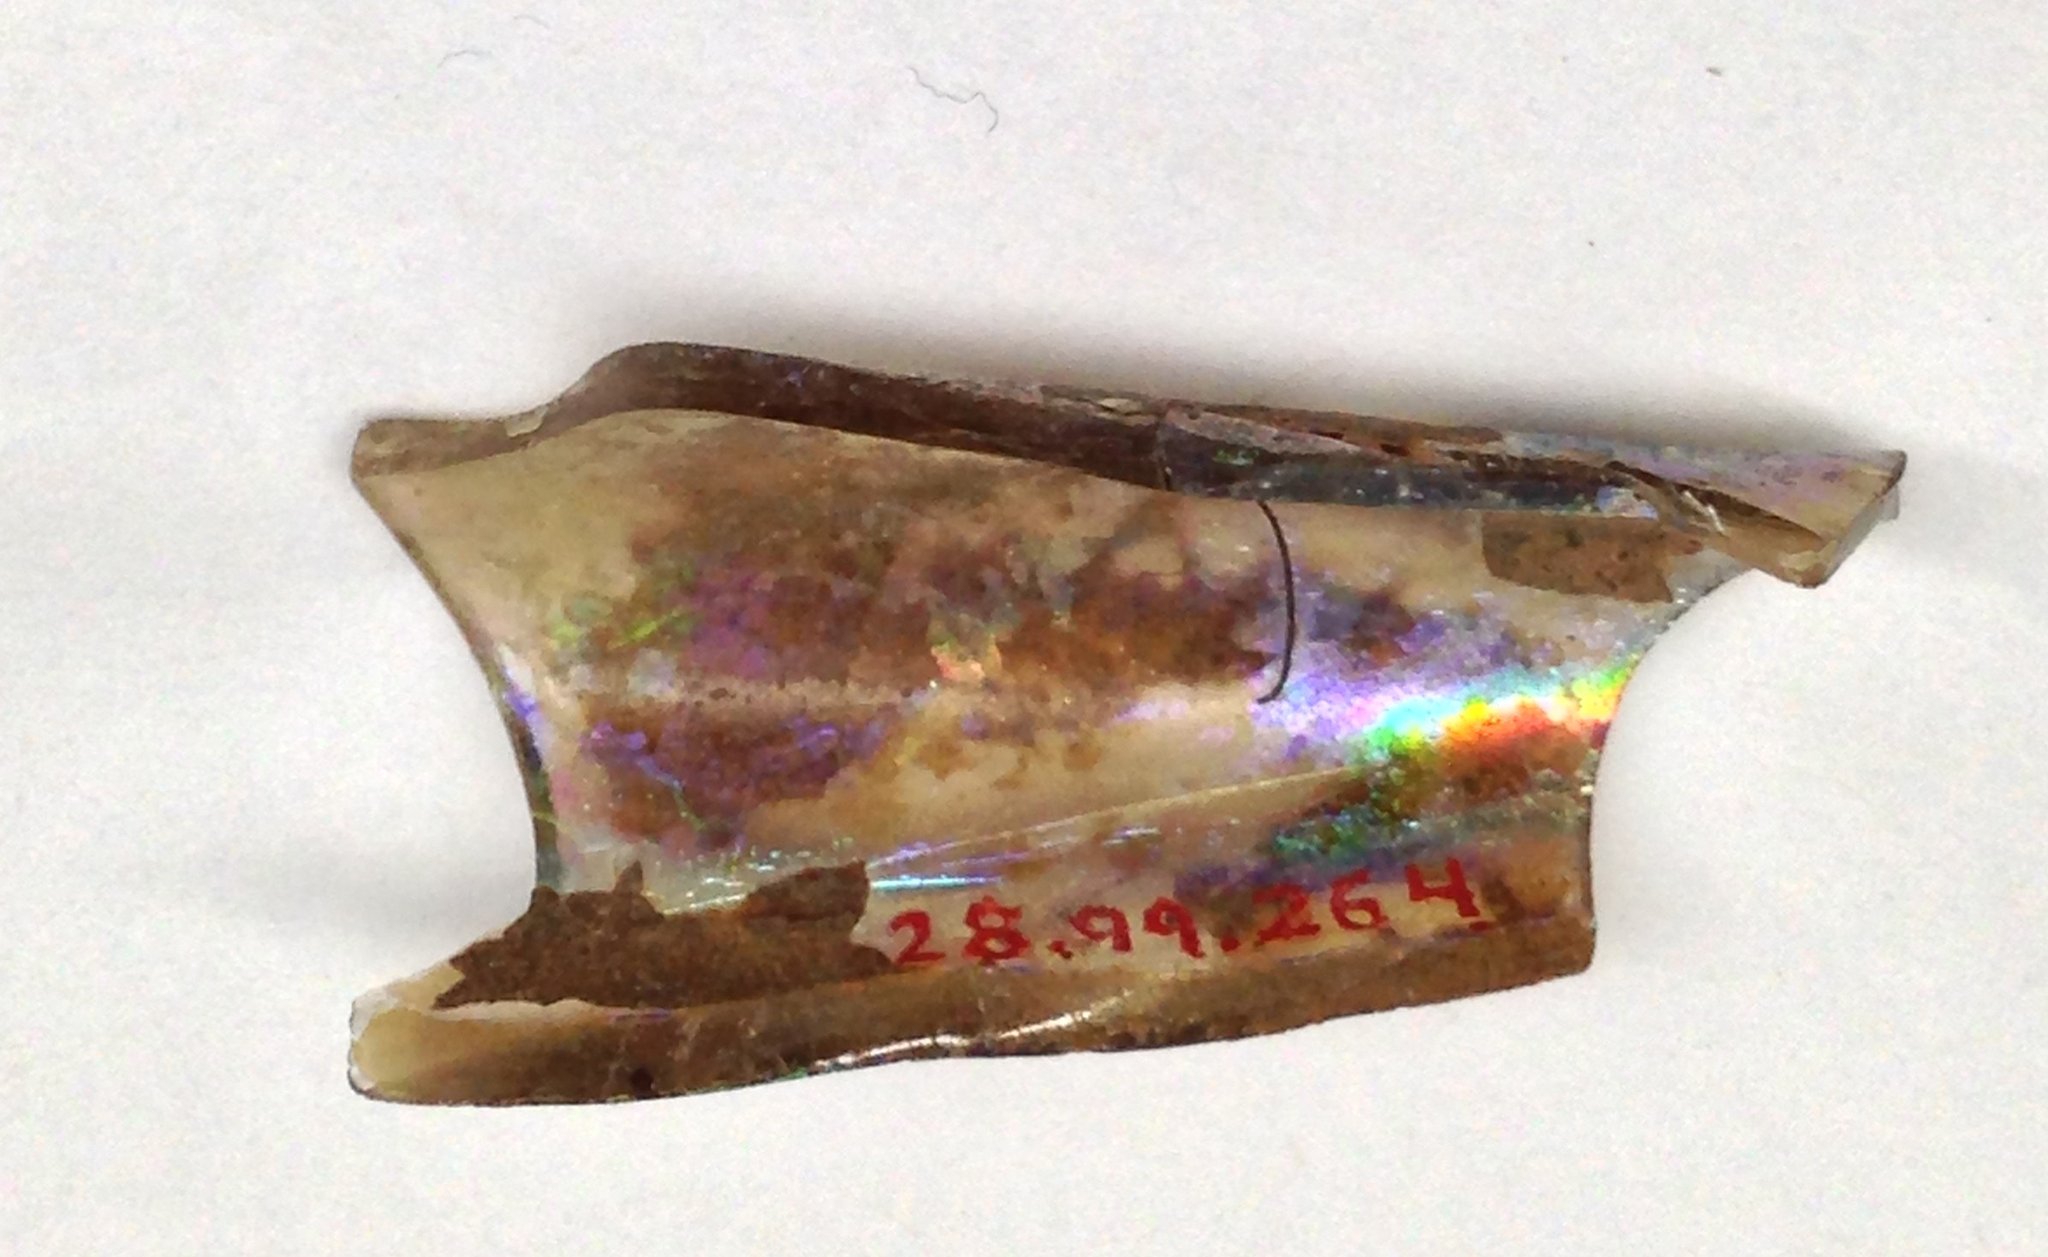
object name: fragment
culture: european or middle eastern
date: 1150-1250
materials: ceramic, glass